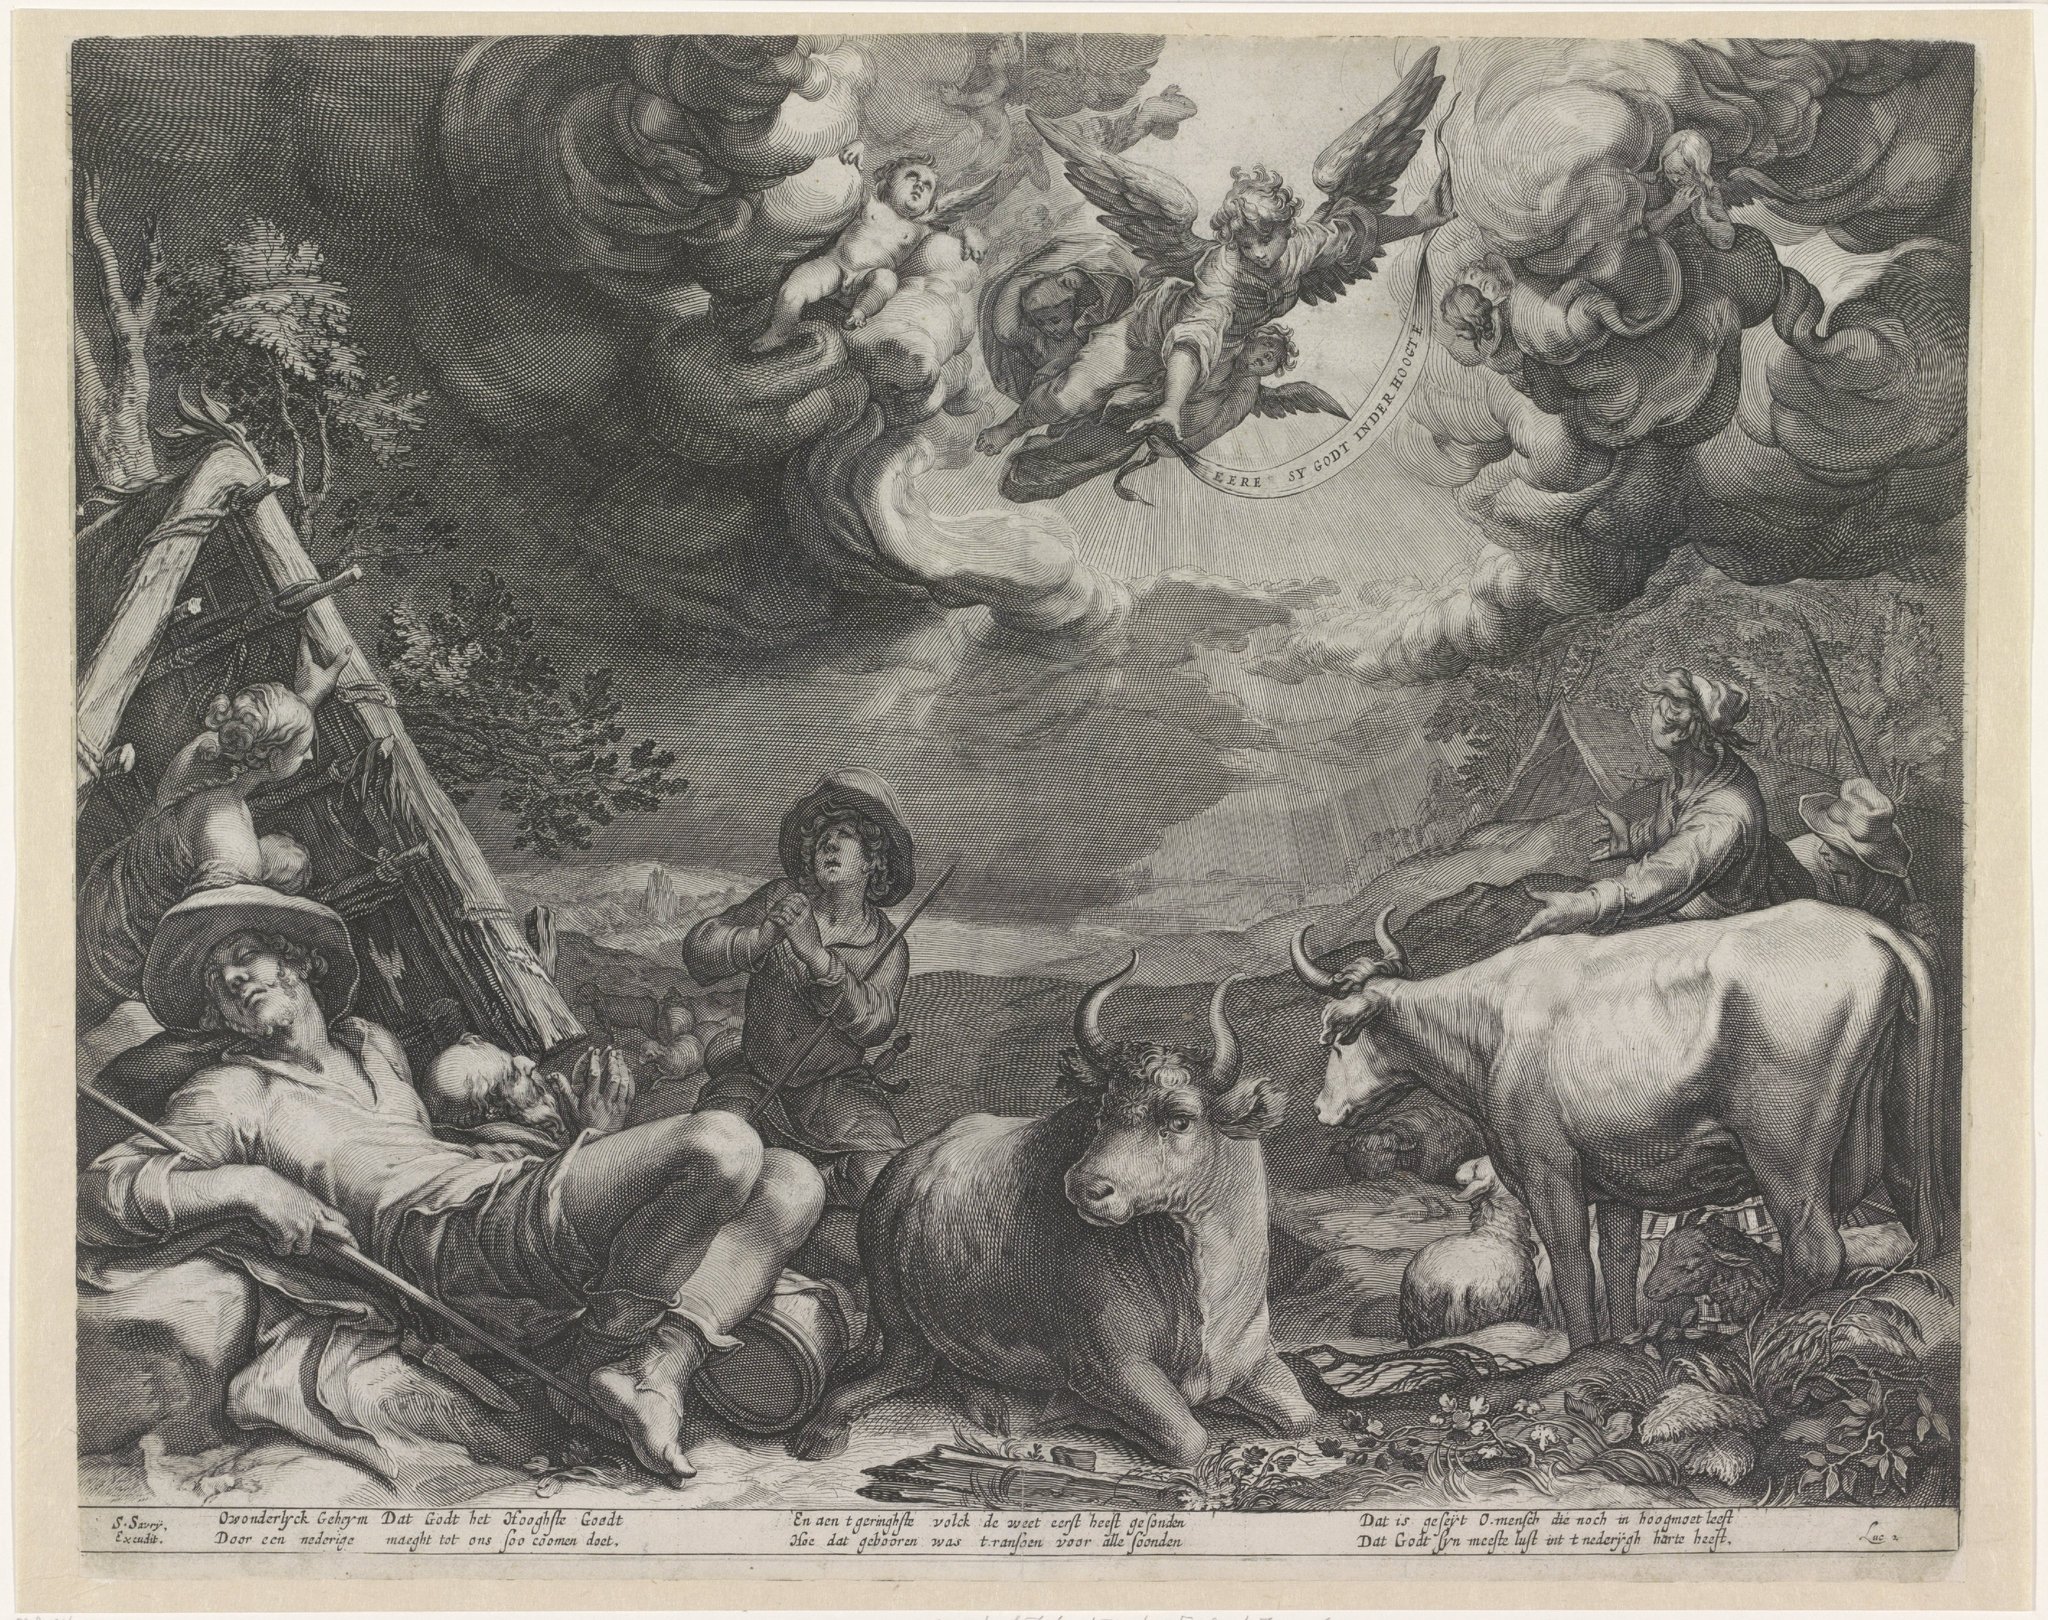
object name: print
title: Royaalbijbel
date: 1630-1665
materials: paper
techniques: engraving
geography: amsterdam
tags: annunciation of christ's birth to the shepherds (and/or shepherdesses) at night; a host of singing angels in the air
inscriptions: collector's mark: Lugt 2228, signature and date: ‘l.o. in de rand: S. Savry Excudit’, inscription: ‘In de onderrand 3 kolommen van 2 regels Nederlandse tekst: O wonderlijck Geheym Dat Godt het Hooogste Goedt Door een nederige maeght tot ons soo coomen doet ....Dat Godt sijn meeste lust int t nederijgh harte heeft. Luc a .’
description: Verschillende Amsterdamse uitgevers gaven vanaf de jaren ’30 van de zeventiende eeuw grote Bijbelse prenten op zogenaamd royaal-formaat papier (ca. 480 x 580 mm) uit. De uitgave van royaalbijbelprenten door de firma Visscher van Claes Jansz. Visscher (II), Nicolaes Visscher (I) en (II) is het meest bekend, maar ook uitgevers als Clement de Jonghe, Cornelis Danckerts brachten deze populaire prenten op de markt. Mogelijk is deze prent ook als royaalbijbelprent uitgegeven.